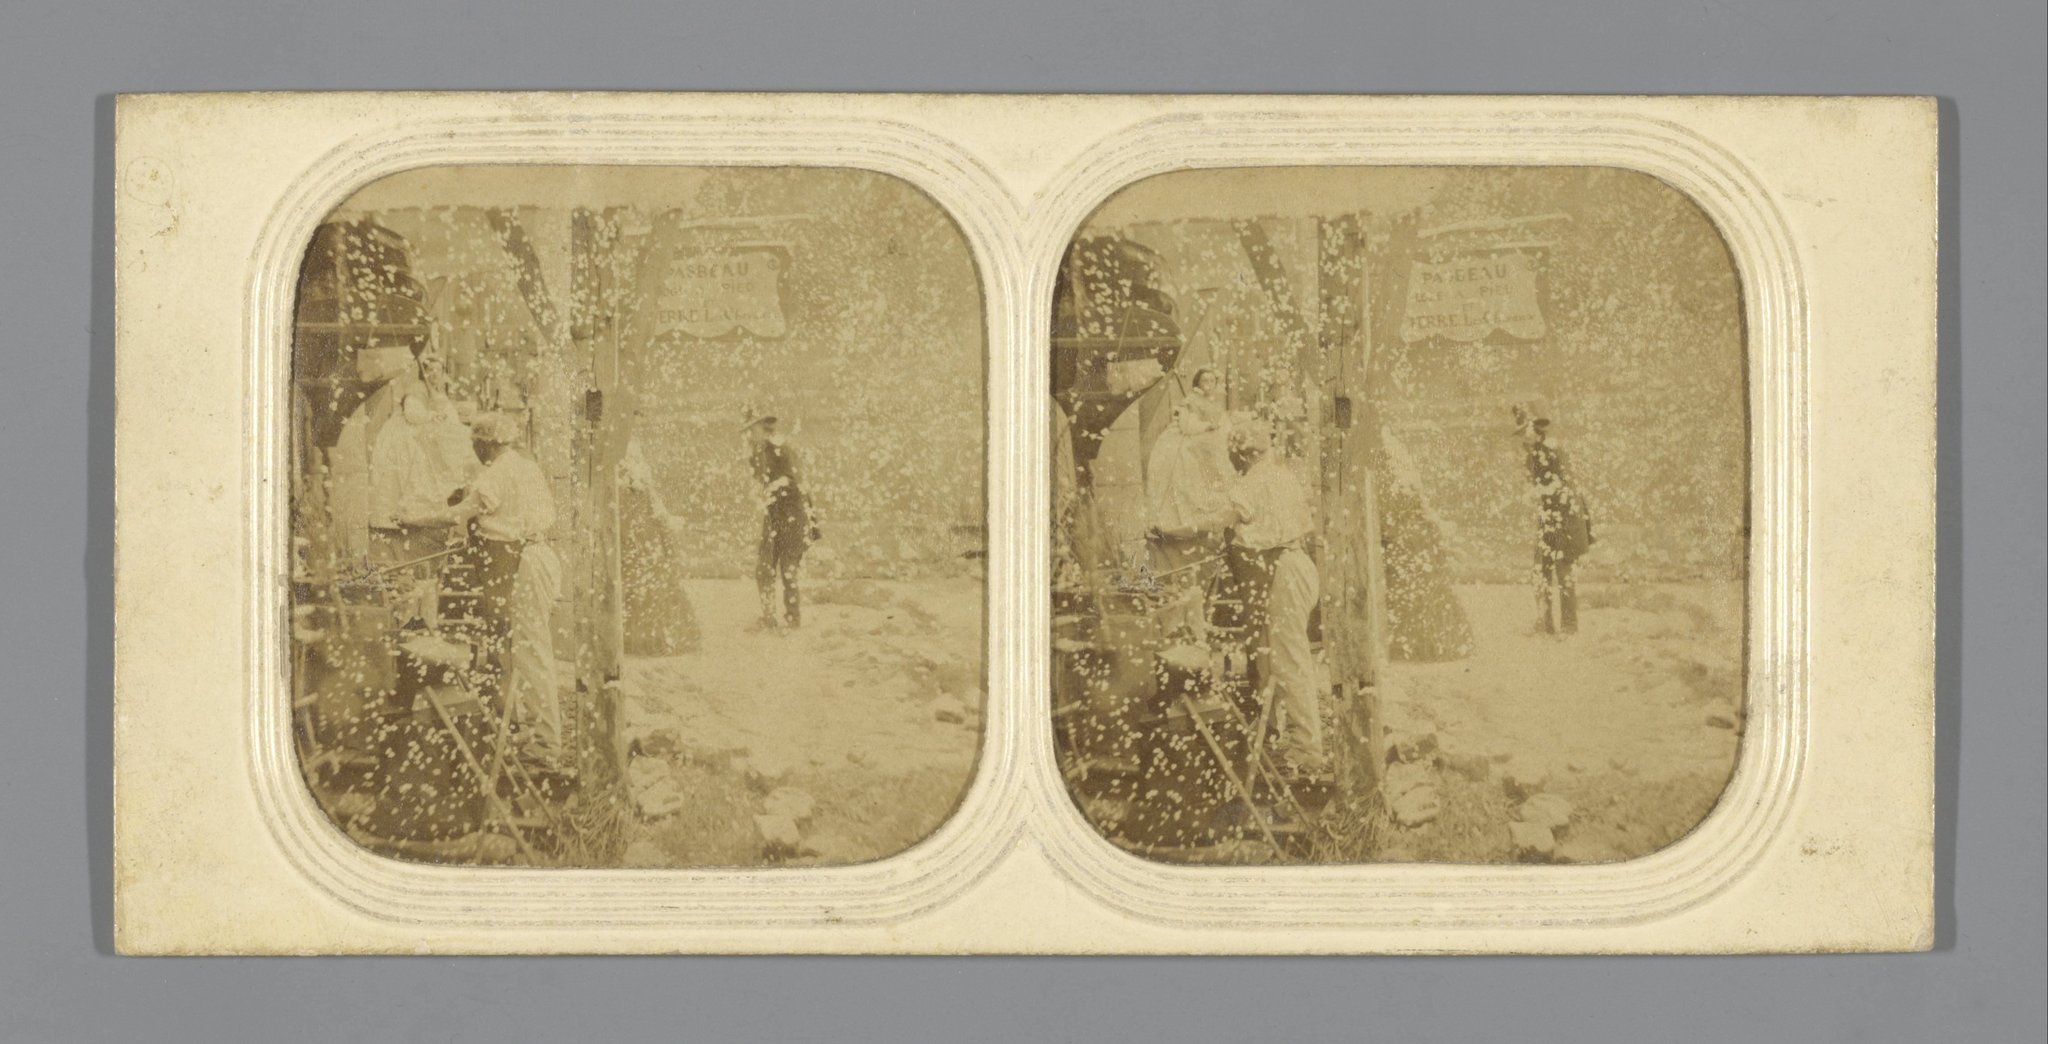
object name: tissue stereograph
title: Straatgezicht met smederij in de sneeuw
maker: Anonymous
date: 1855-1875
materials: cardboard, paper, photographic support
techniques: albumen print, cutting, hand coloring, perforating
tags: snow, smith, blacksmith, street